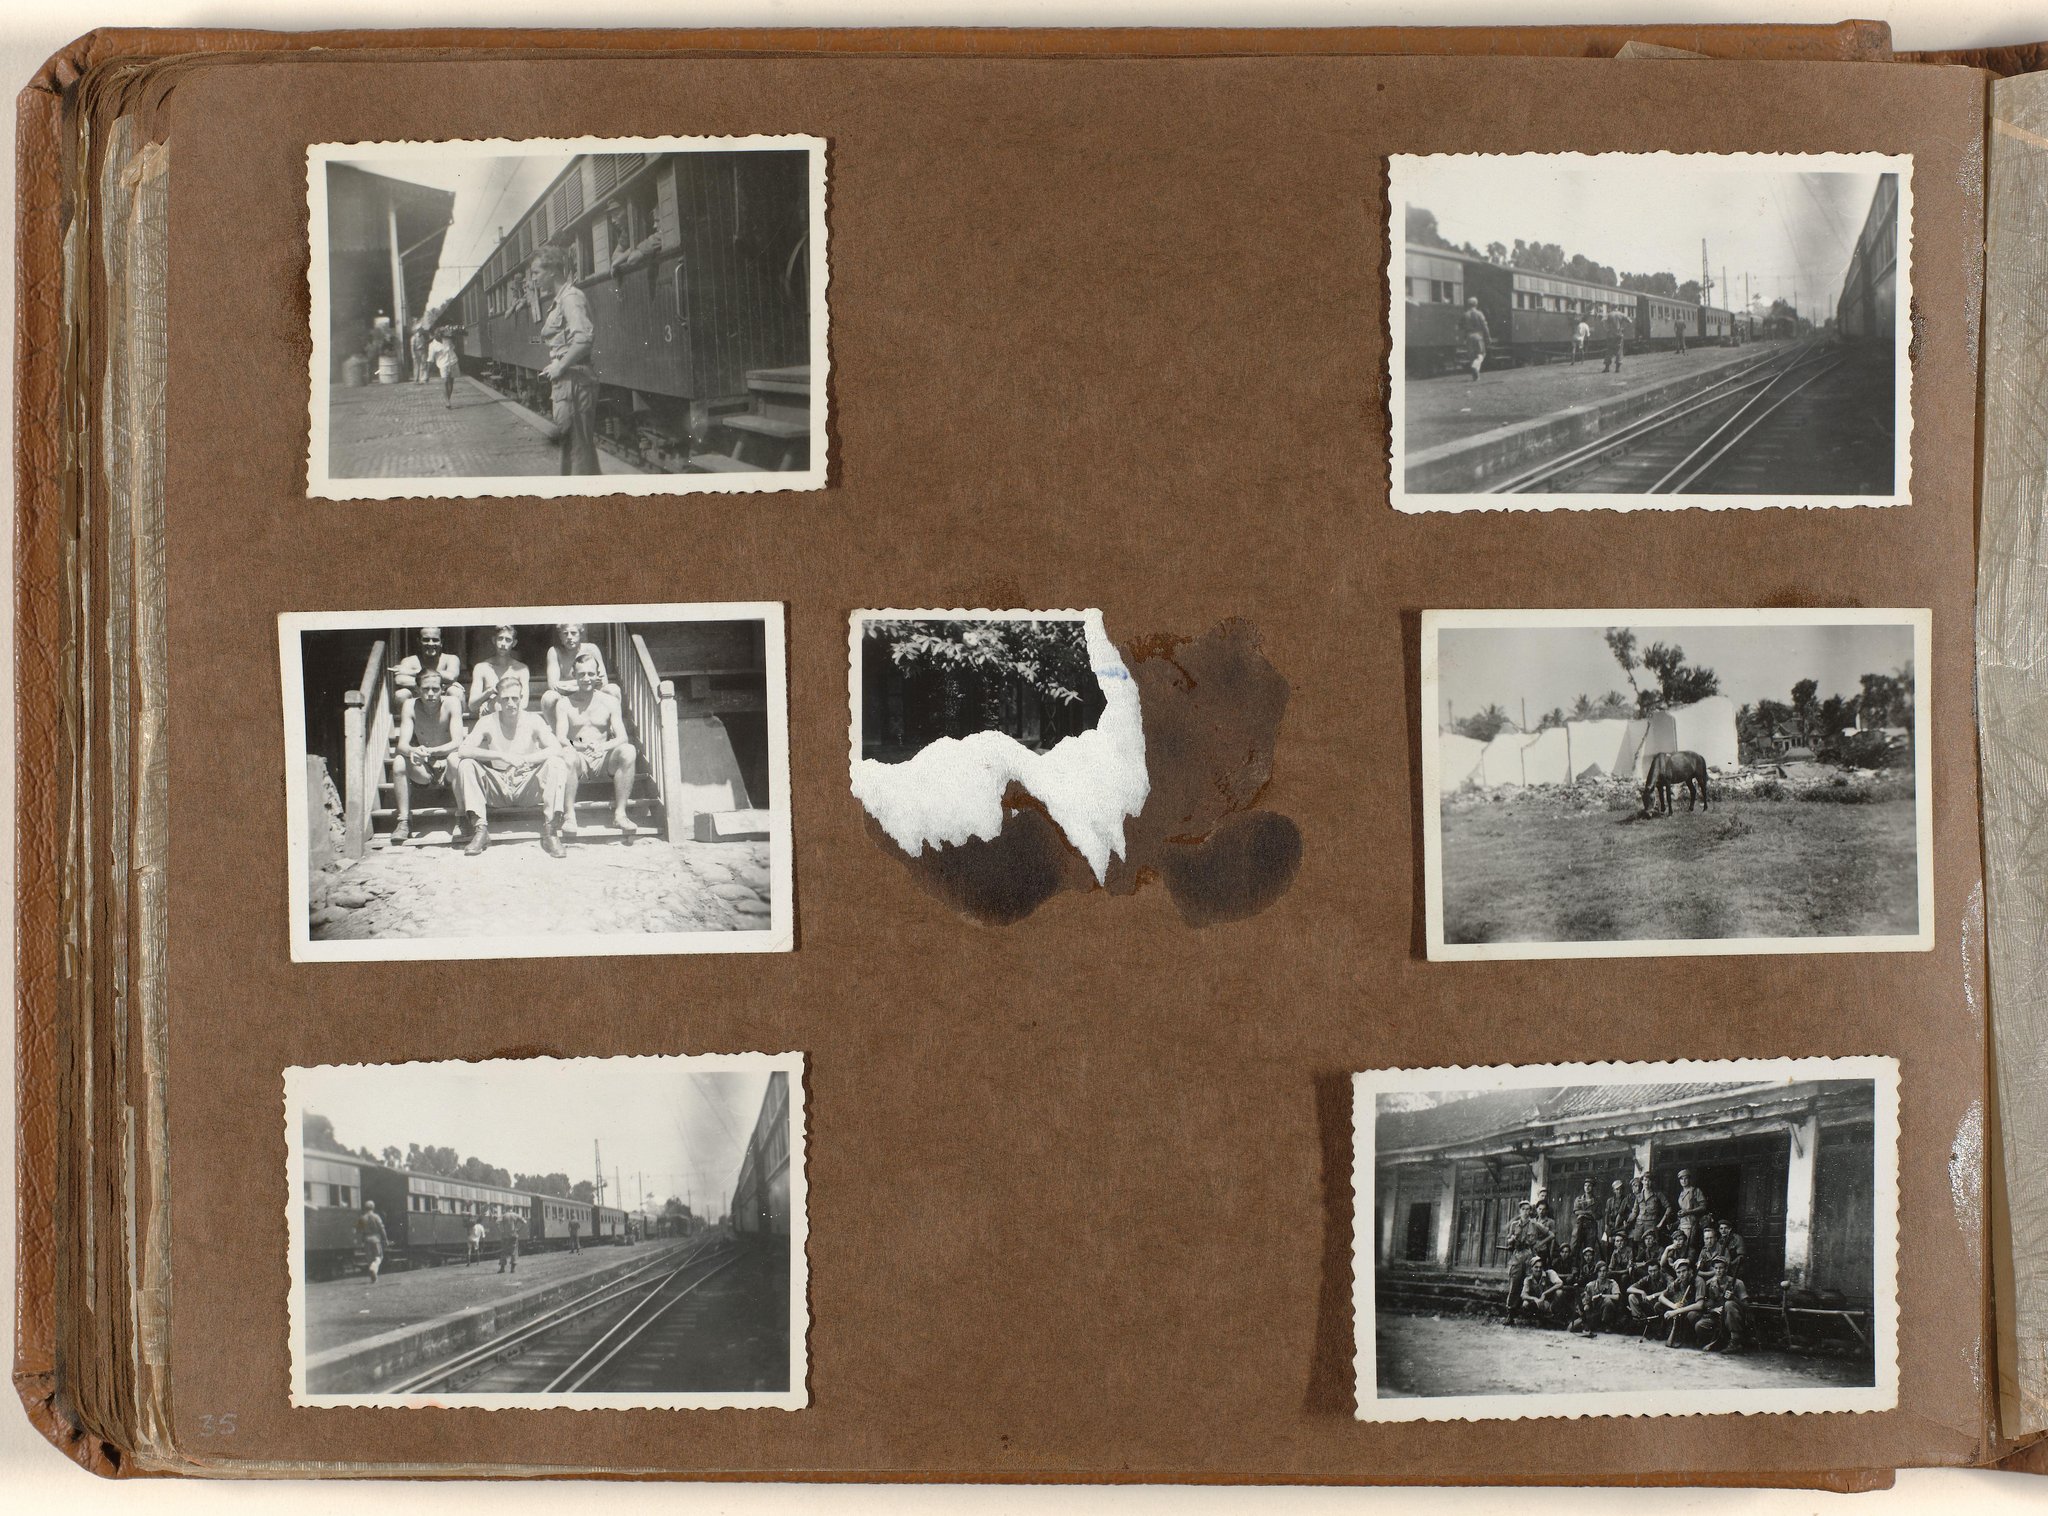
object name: photograph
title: Treinstation Soerabaja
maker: Anonymous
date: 1949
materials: paper, photographic support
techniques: photography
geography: surabaya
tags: the company, the unit, the troop ~ military service, station; shelter (railway, tramway), dutch east indies, the, surabaya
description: Albumblad met zeven foto's. Drie foto's van een treinstation, waarschijnlijk in of bij Soerabaja, met soldaten op het perron. Ook twee groepsfoto's van Nederlandse soldaten op de trappen van een verblijf. Ook een foto van een verwoest gebouw, alleen de muren staan nog overeind, op de voorgrond graast een een paard.